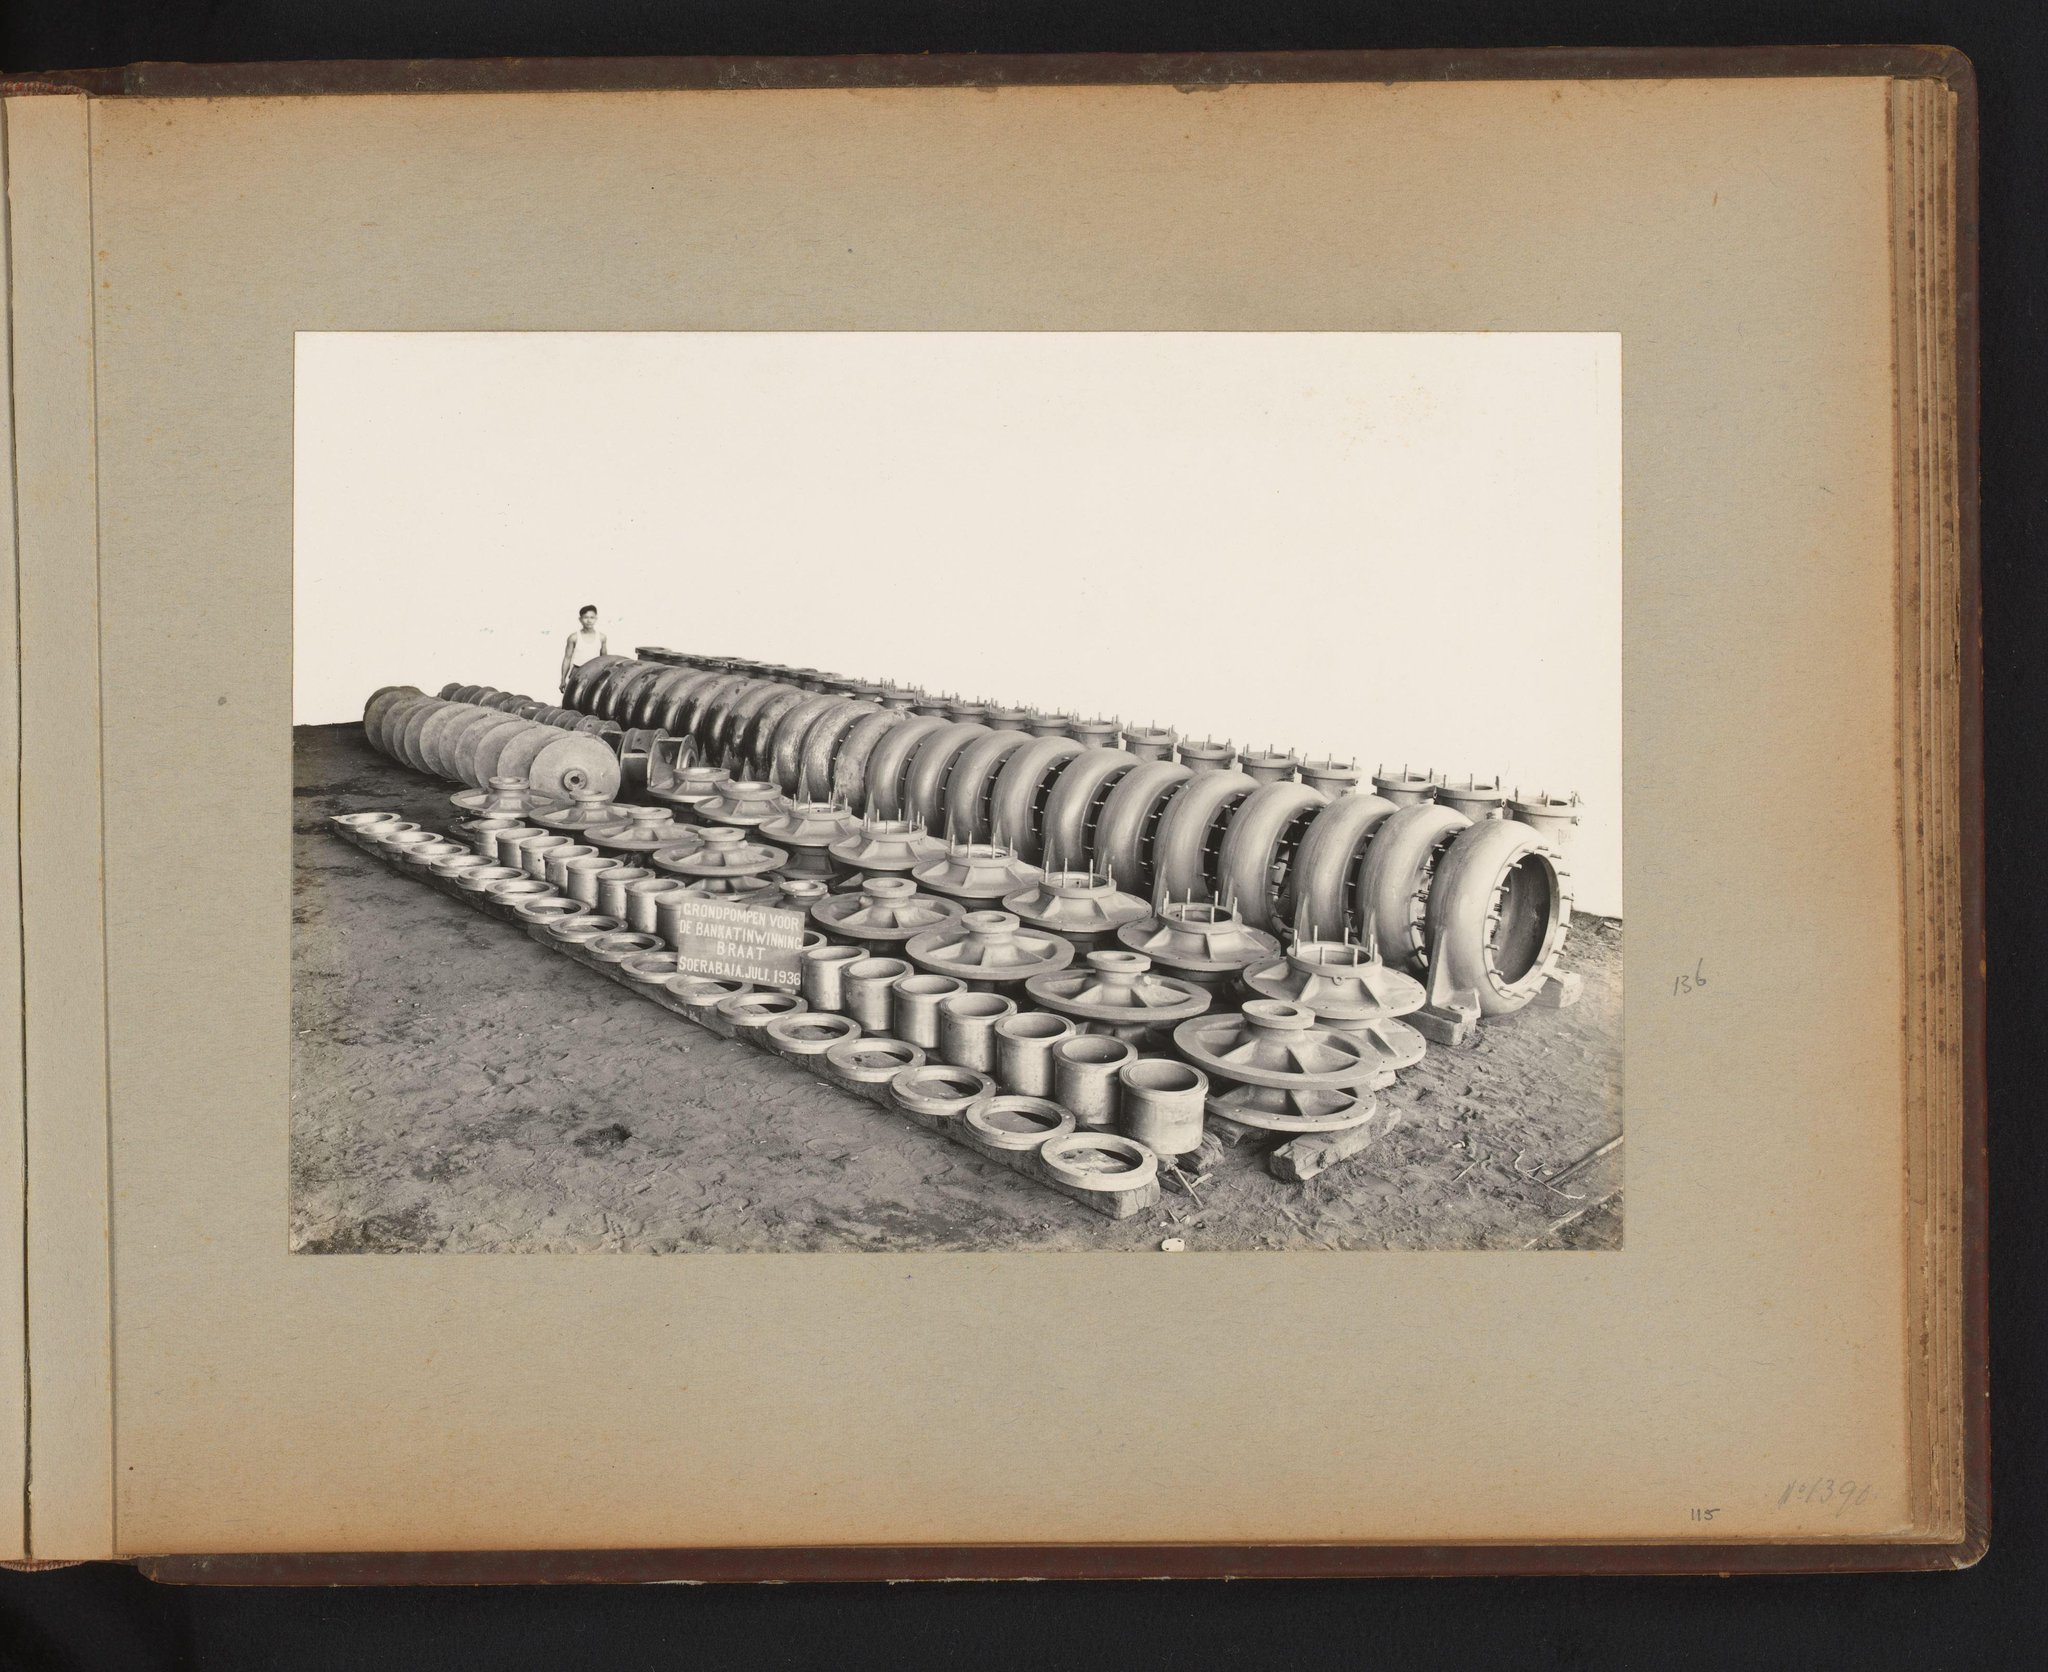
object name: photograph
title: Grondpompen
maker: Anonymous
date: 1907-1936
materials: cardboard, photographic support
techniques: gelatin silver print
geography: surabaya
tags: machines; parts of machines; tools and appliances, java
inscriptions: date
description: Albumblad met een foto van een uitstalling van grondpompen, vervaardigd in 1936 en bestemd voor de Banka Tinwinning, juli 1936. Onderdeel van een fotoalbum met foto's van machines en constructies van de N.V. Machinefabriek Braat te Soerabaja, Soekaboemi en Tegal uit de periode 1931-1937.